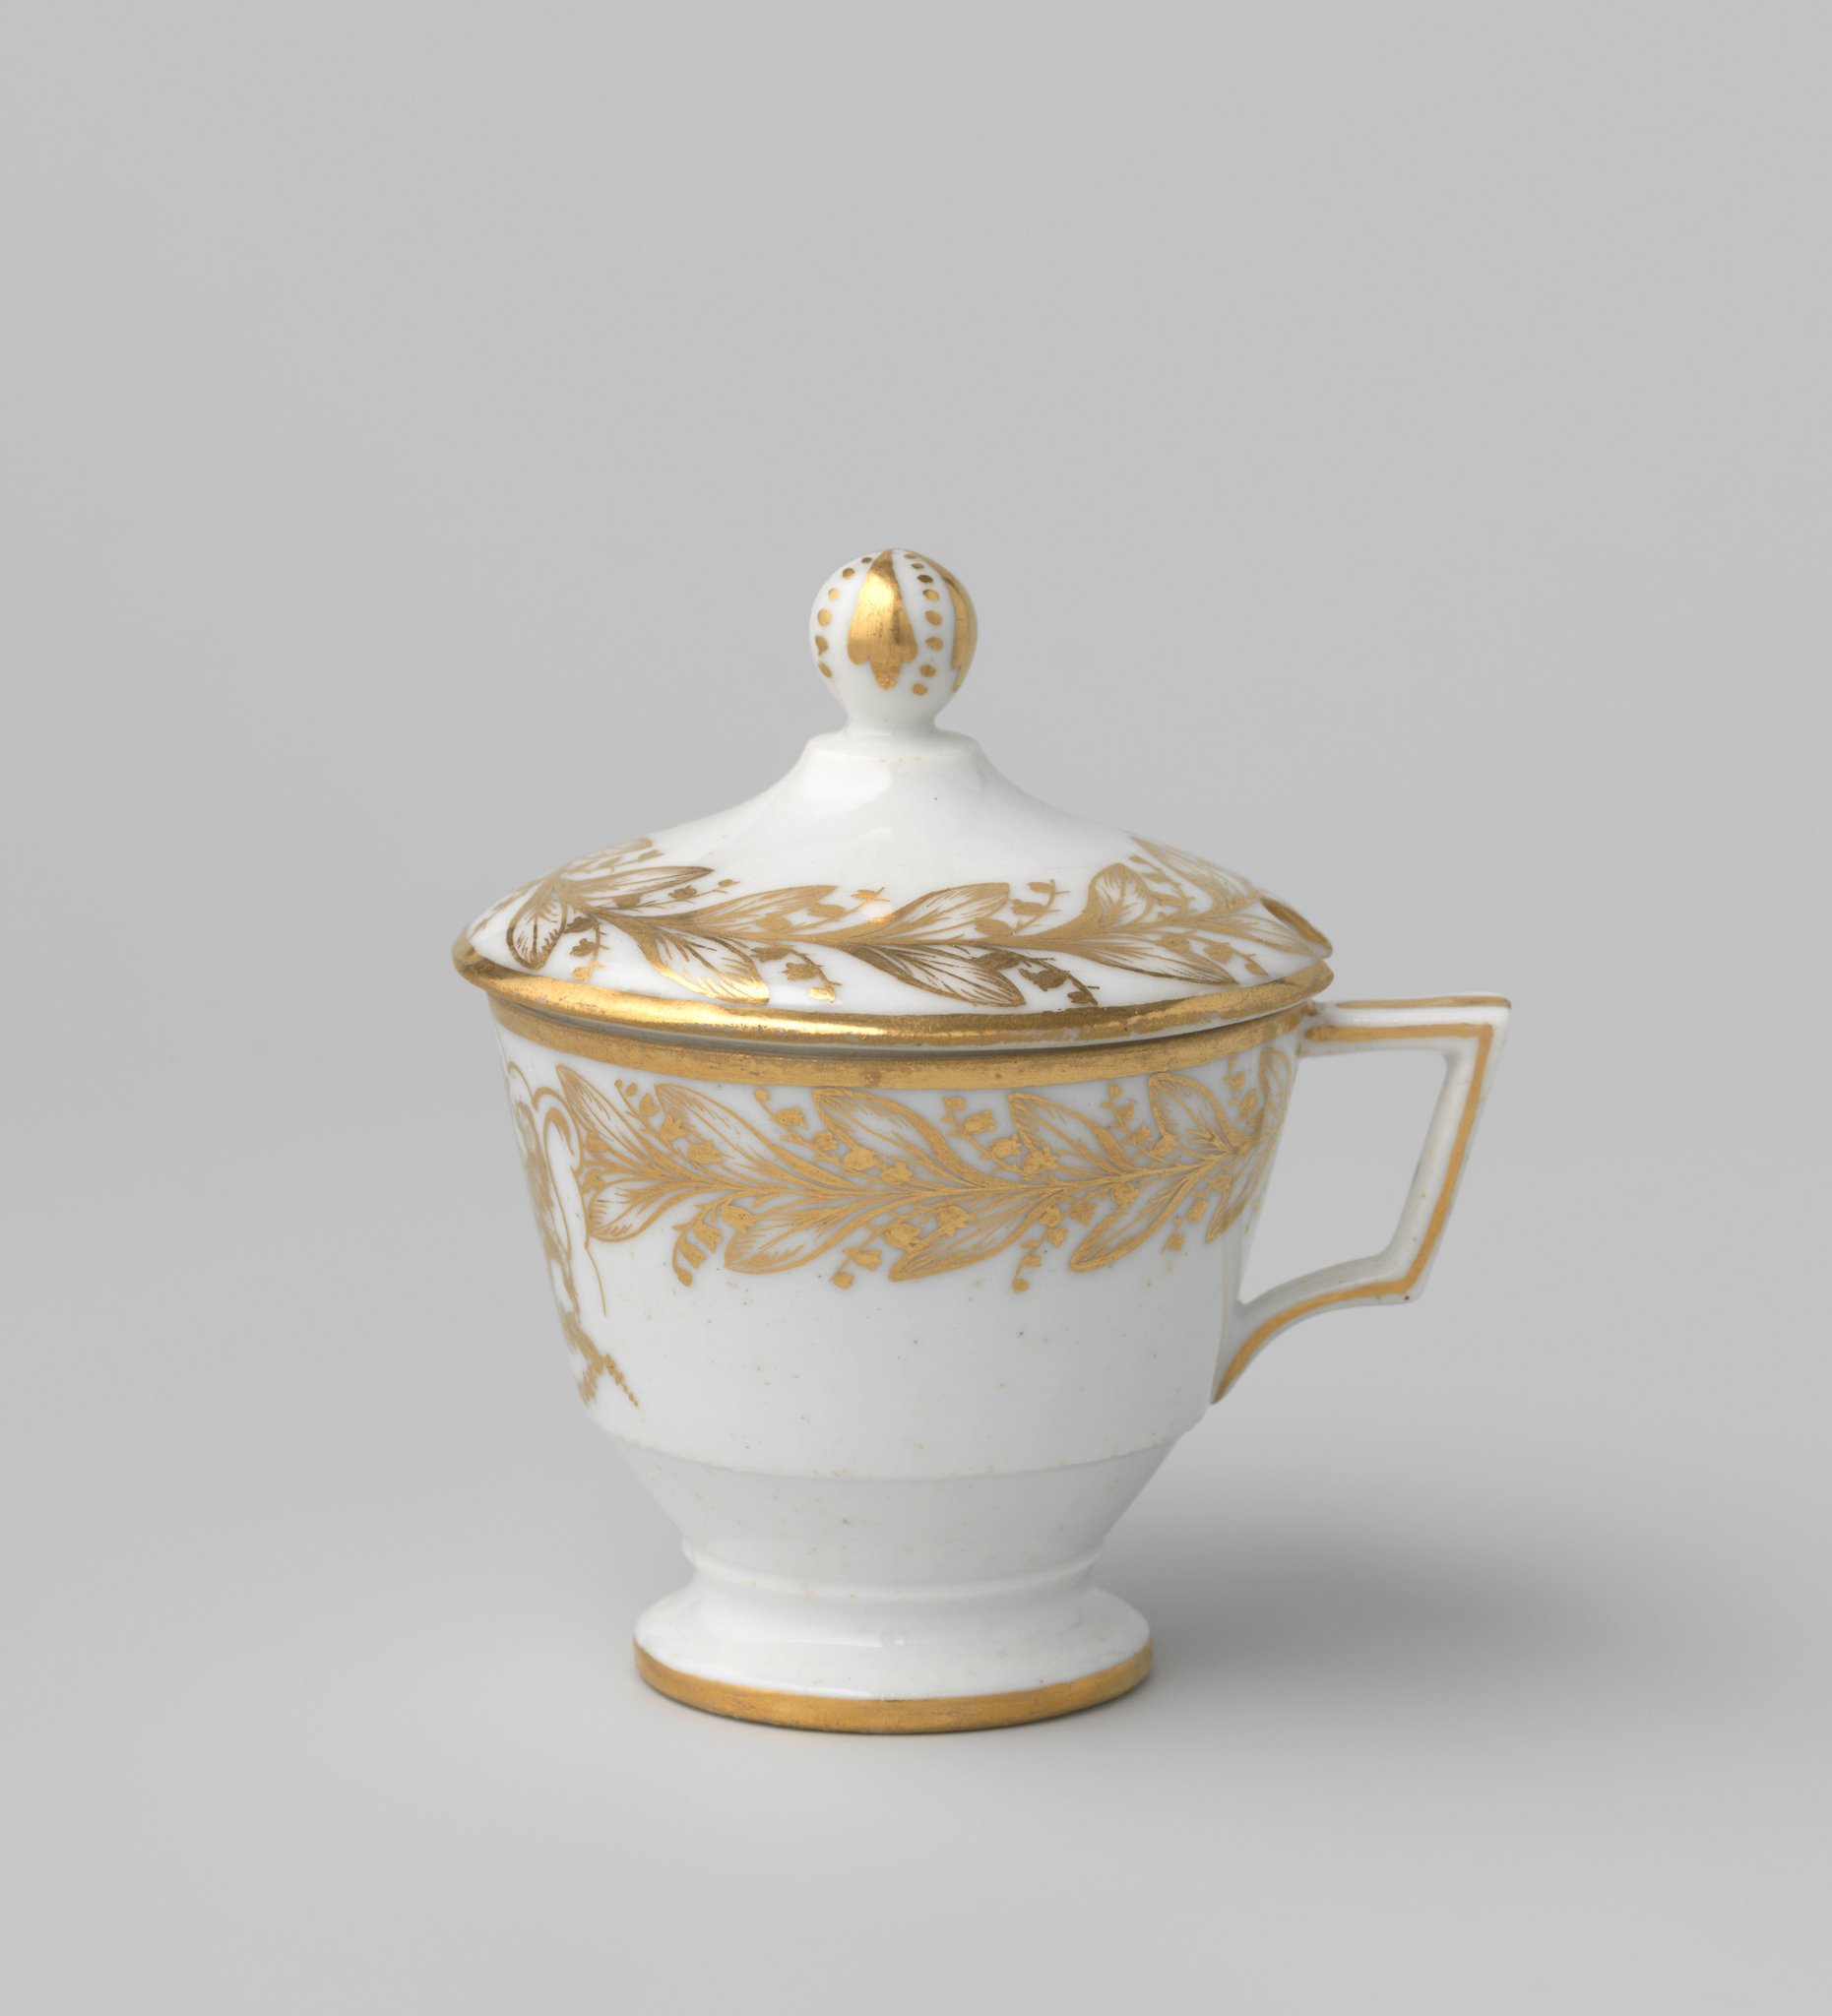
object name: service set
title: Mustard pot with the coat of arms of Hendrik Peter Godfried Quack and Isabella Gertraud von Carnap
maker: Anonymous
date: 1790-1800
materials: glaze, gold, paint, porcelain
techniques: firing, forming, gilding, turning, vitrification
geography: netherlands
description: Mosterpot van porselein op hoge voet en met een hoekig oor, beschilderd op het glazuur met goud. Op de buitenwand het alliantiewapen van Hendrik Peter Godfried Quack en Isabella Gertraud von Carnap en een bloemrank. Gouden band op de rand en de voet.